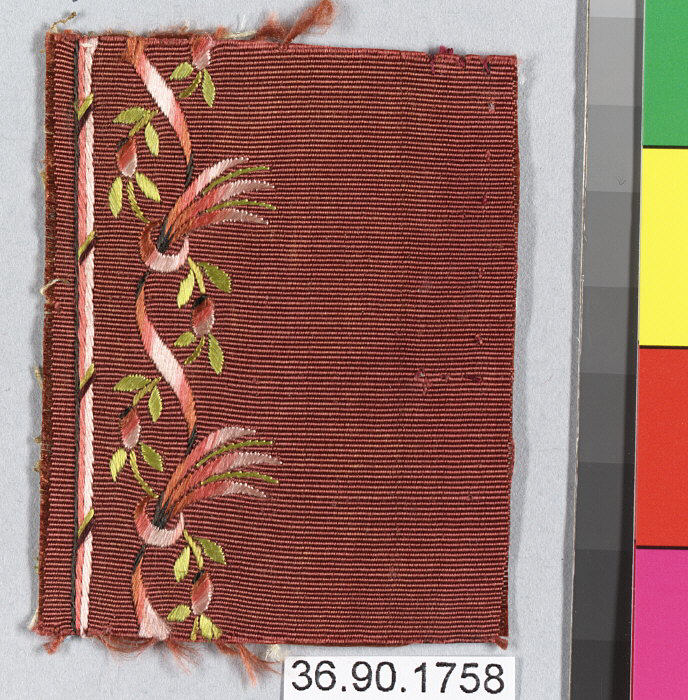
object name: sample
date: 1801-1833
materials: silk